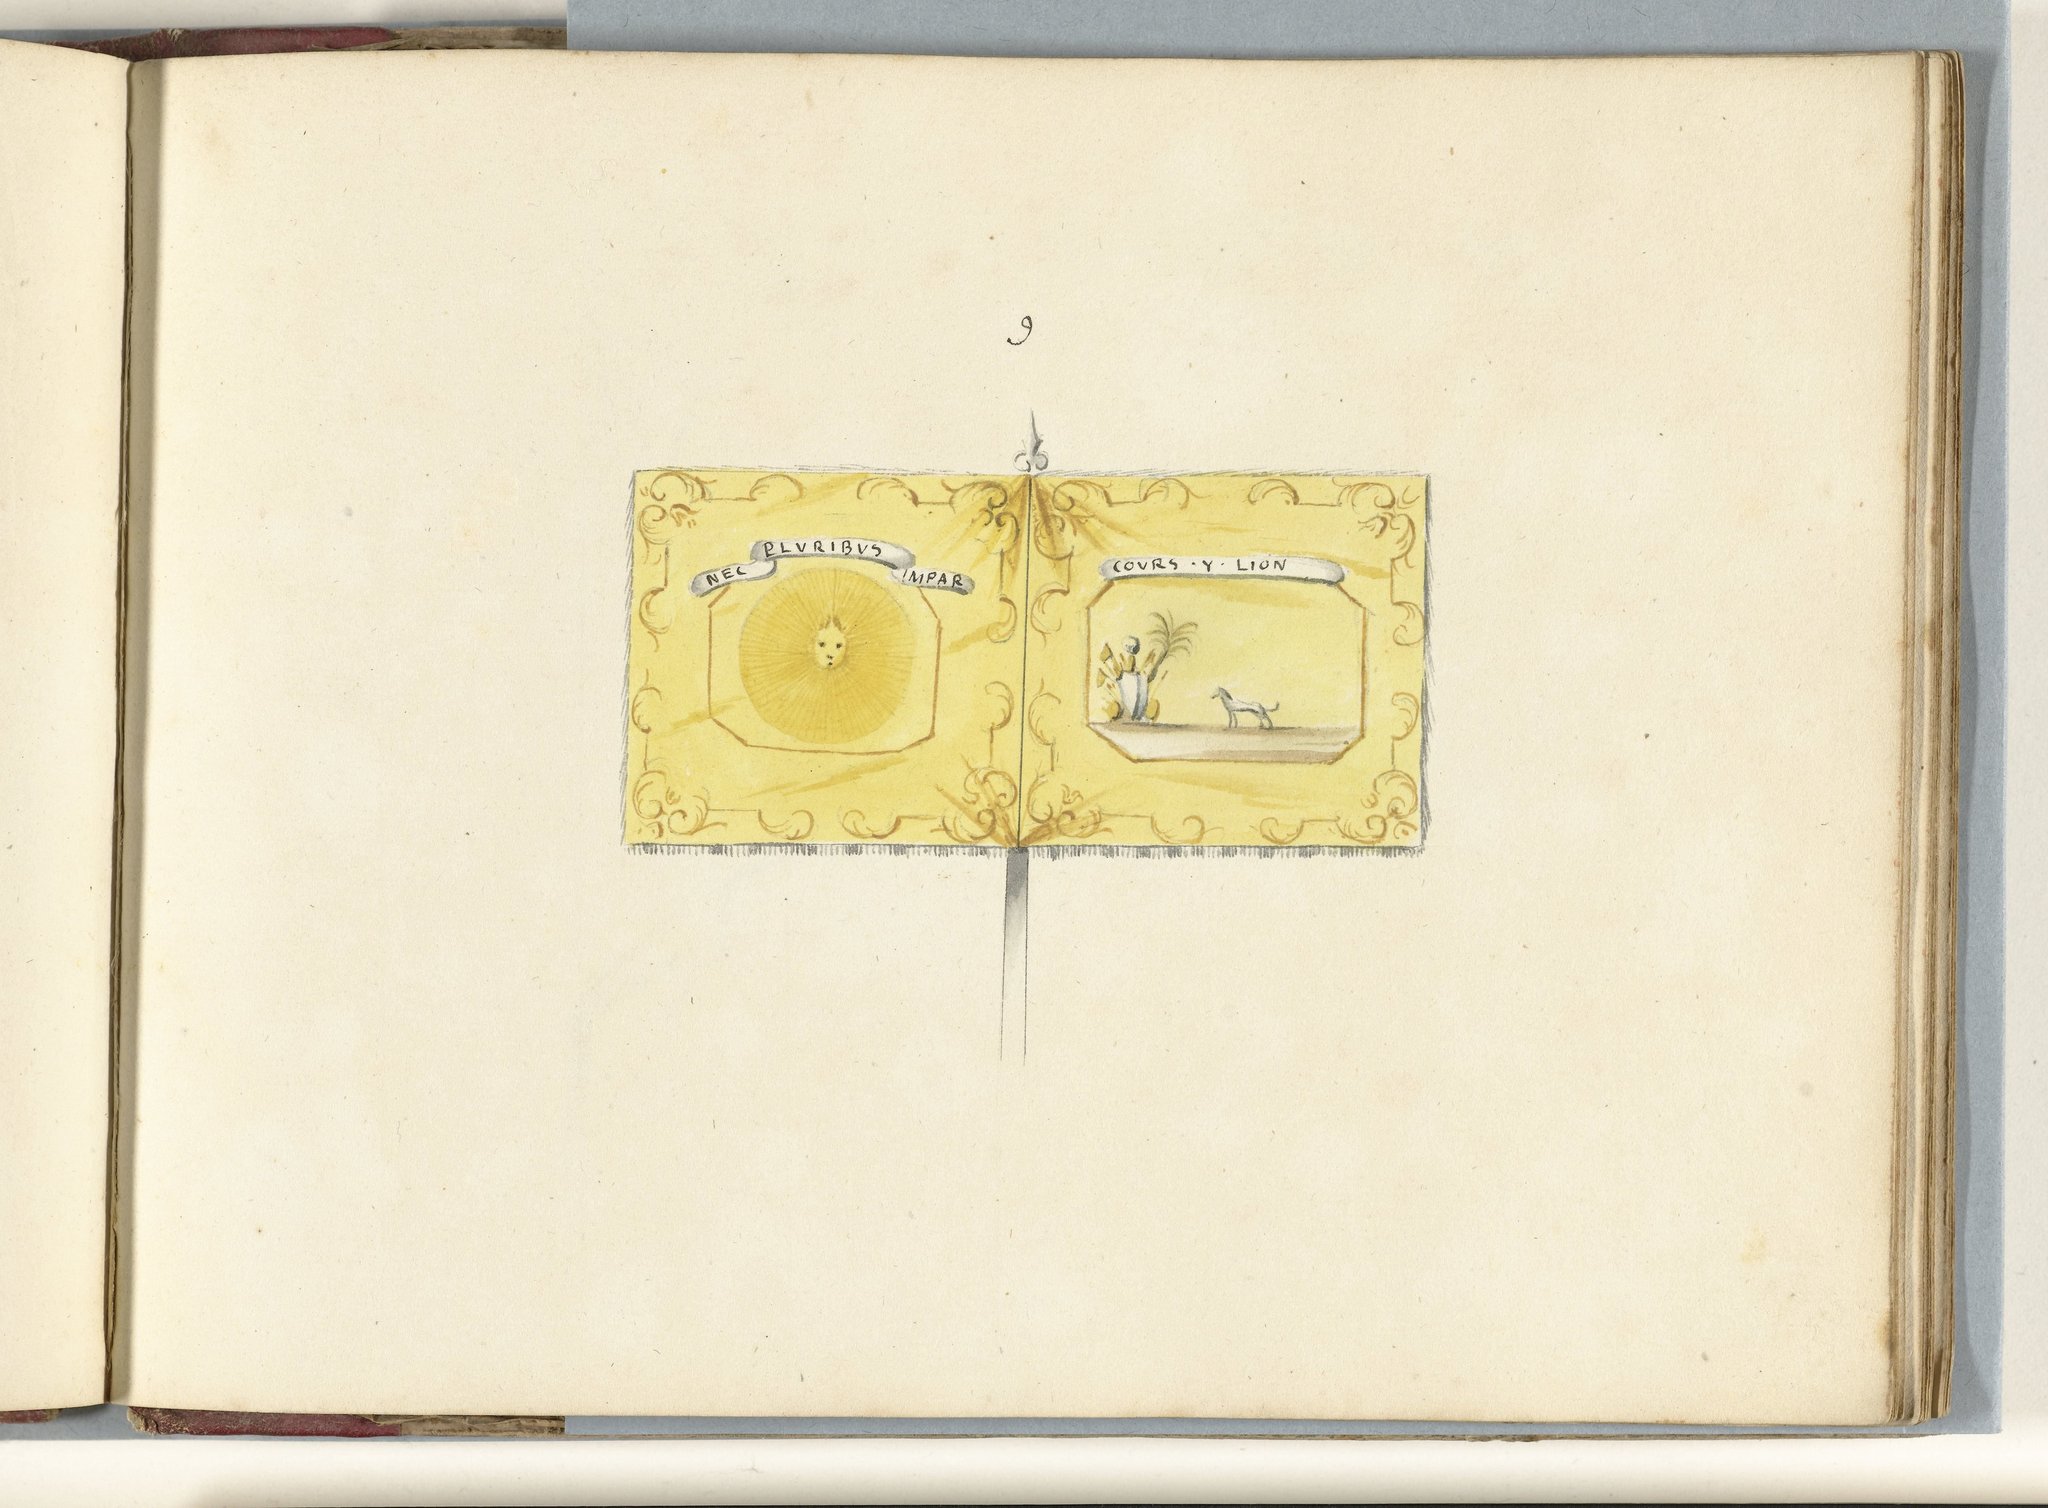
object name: drawing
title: Frans standaard veroverd in de slag bij Malplaquet, 1709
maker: Anonymous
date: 1713-1720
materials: paper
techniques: drawing, writing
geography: northern netherlands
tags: (military) flags and standards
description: Frans standaard veroverd bij de slag bij Malplaquet in 1709. In het boek met tekeningen van Franse vaandels, standaarden en pauken, veroverd tijdens de Spaanse Successieoorlog (1701-1713).